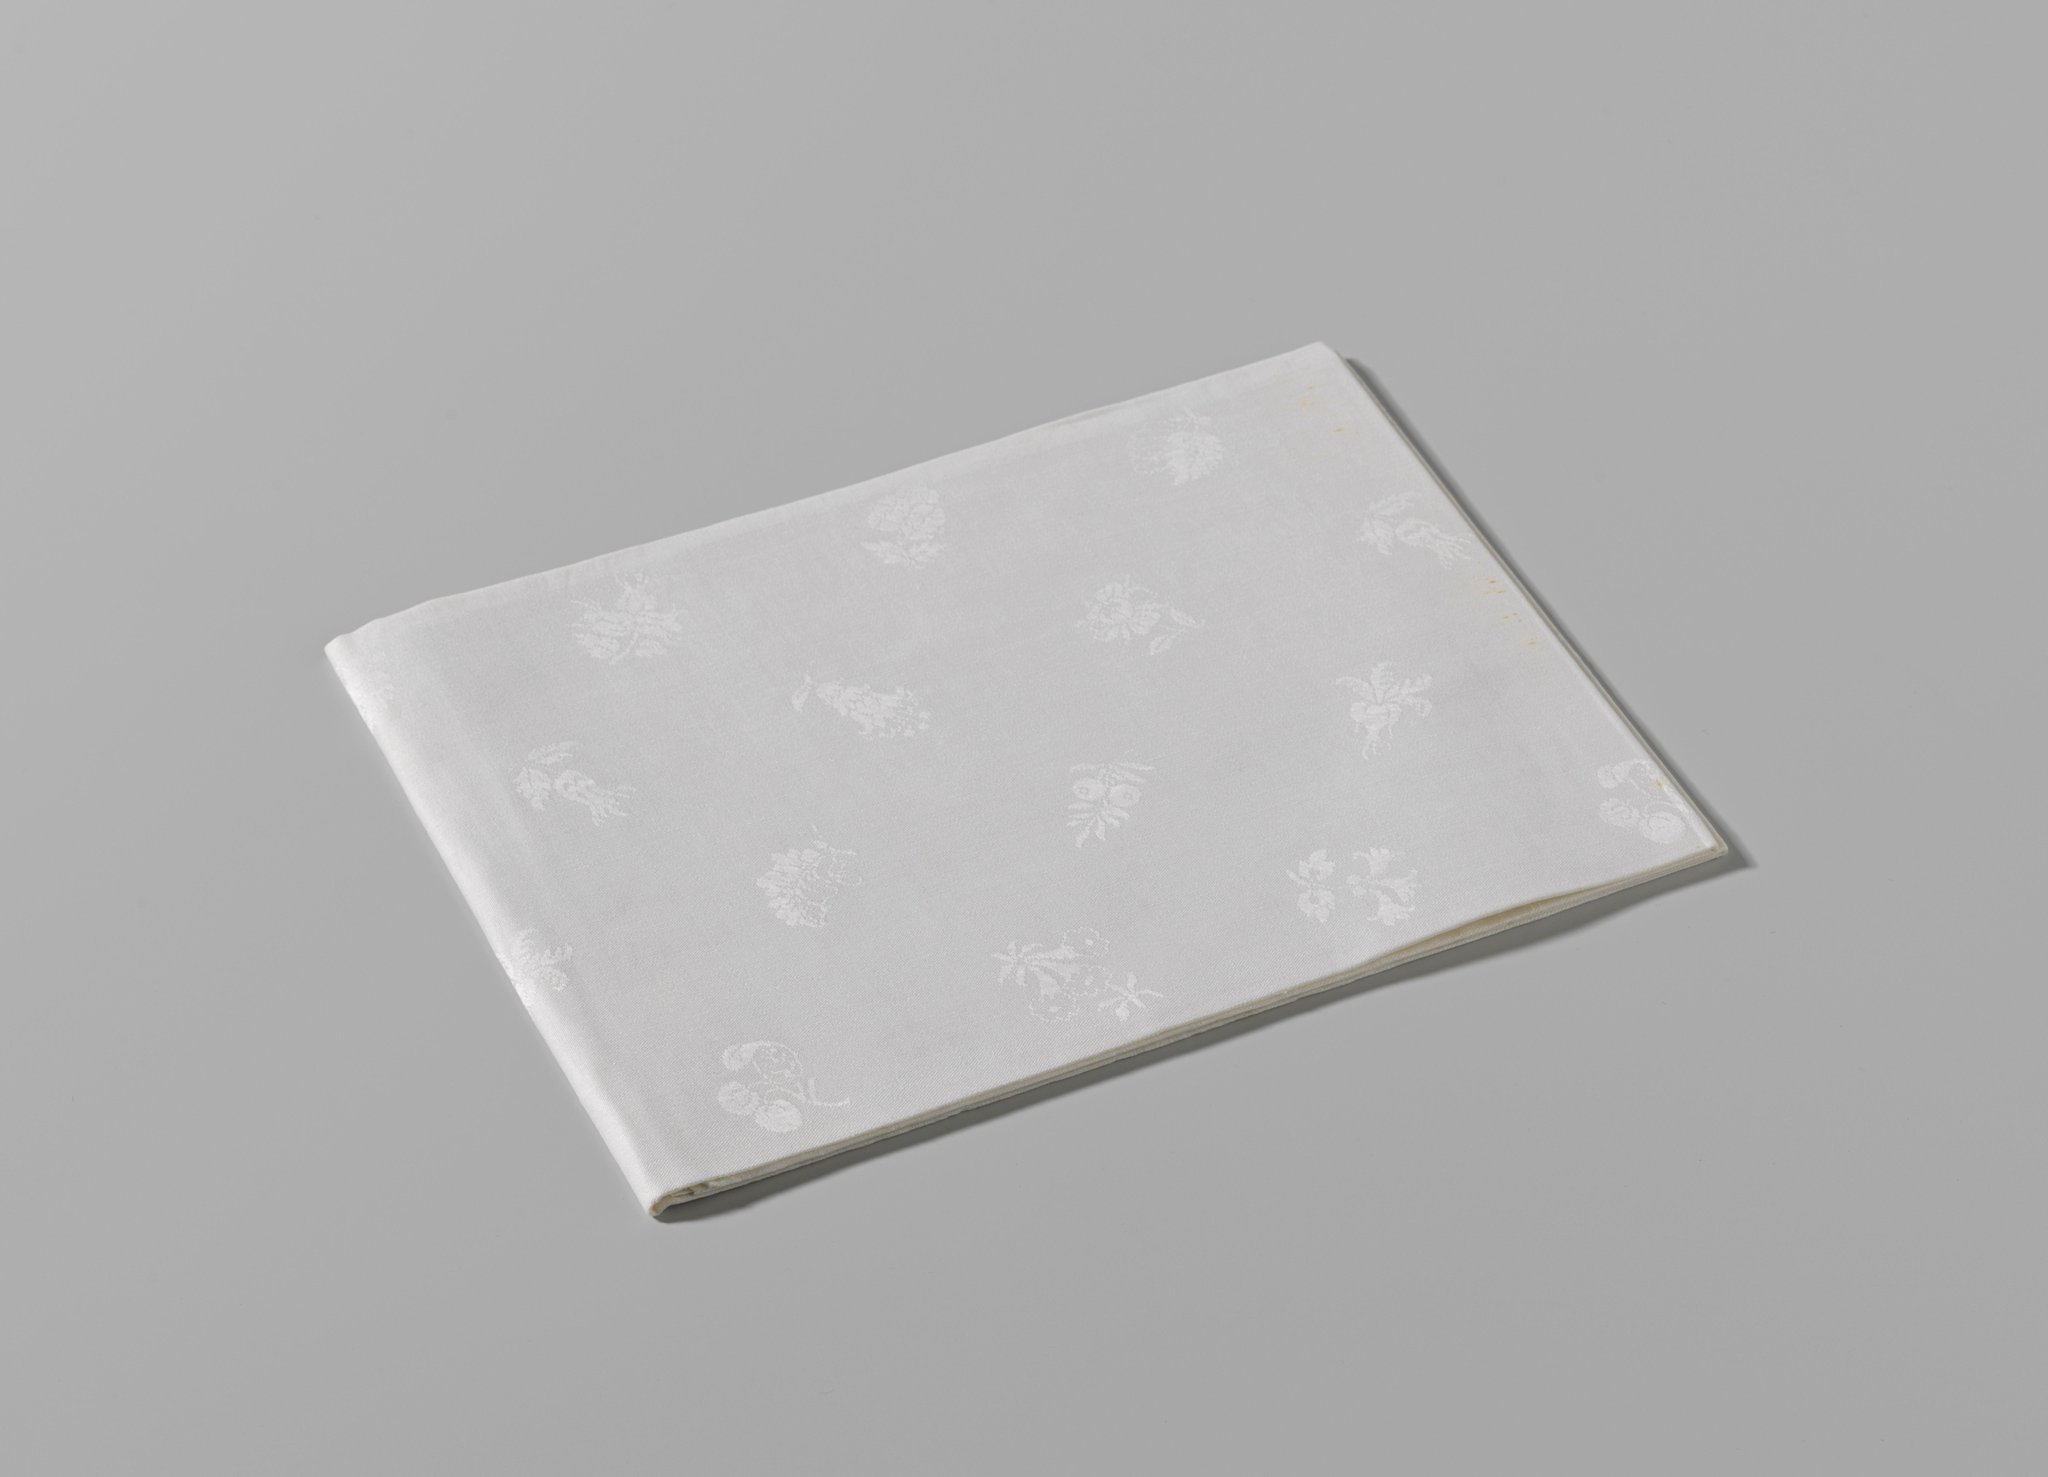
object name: napkin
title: Servet met patroon van diverse vruchten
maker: Anonymous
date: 1800-1900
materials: linen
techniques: damask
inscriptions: label: ‘R.M. A'dam’, mark: ‘36’, monogram: ‘TvBF’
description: Servet van linnendamast met patroon van diverse vruchten en bloemen op het middenveld.